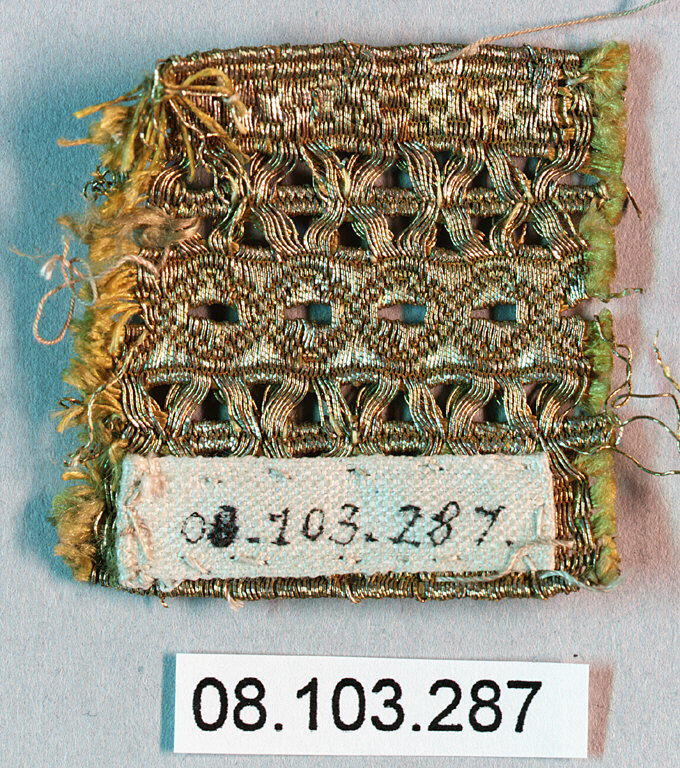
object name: galloon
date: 1601-1800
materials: metal thread, silk